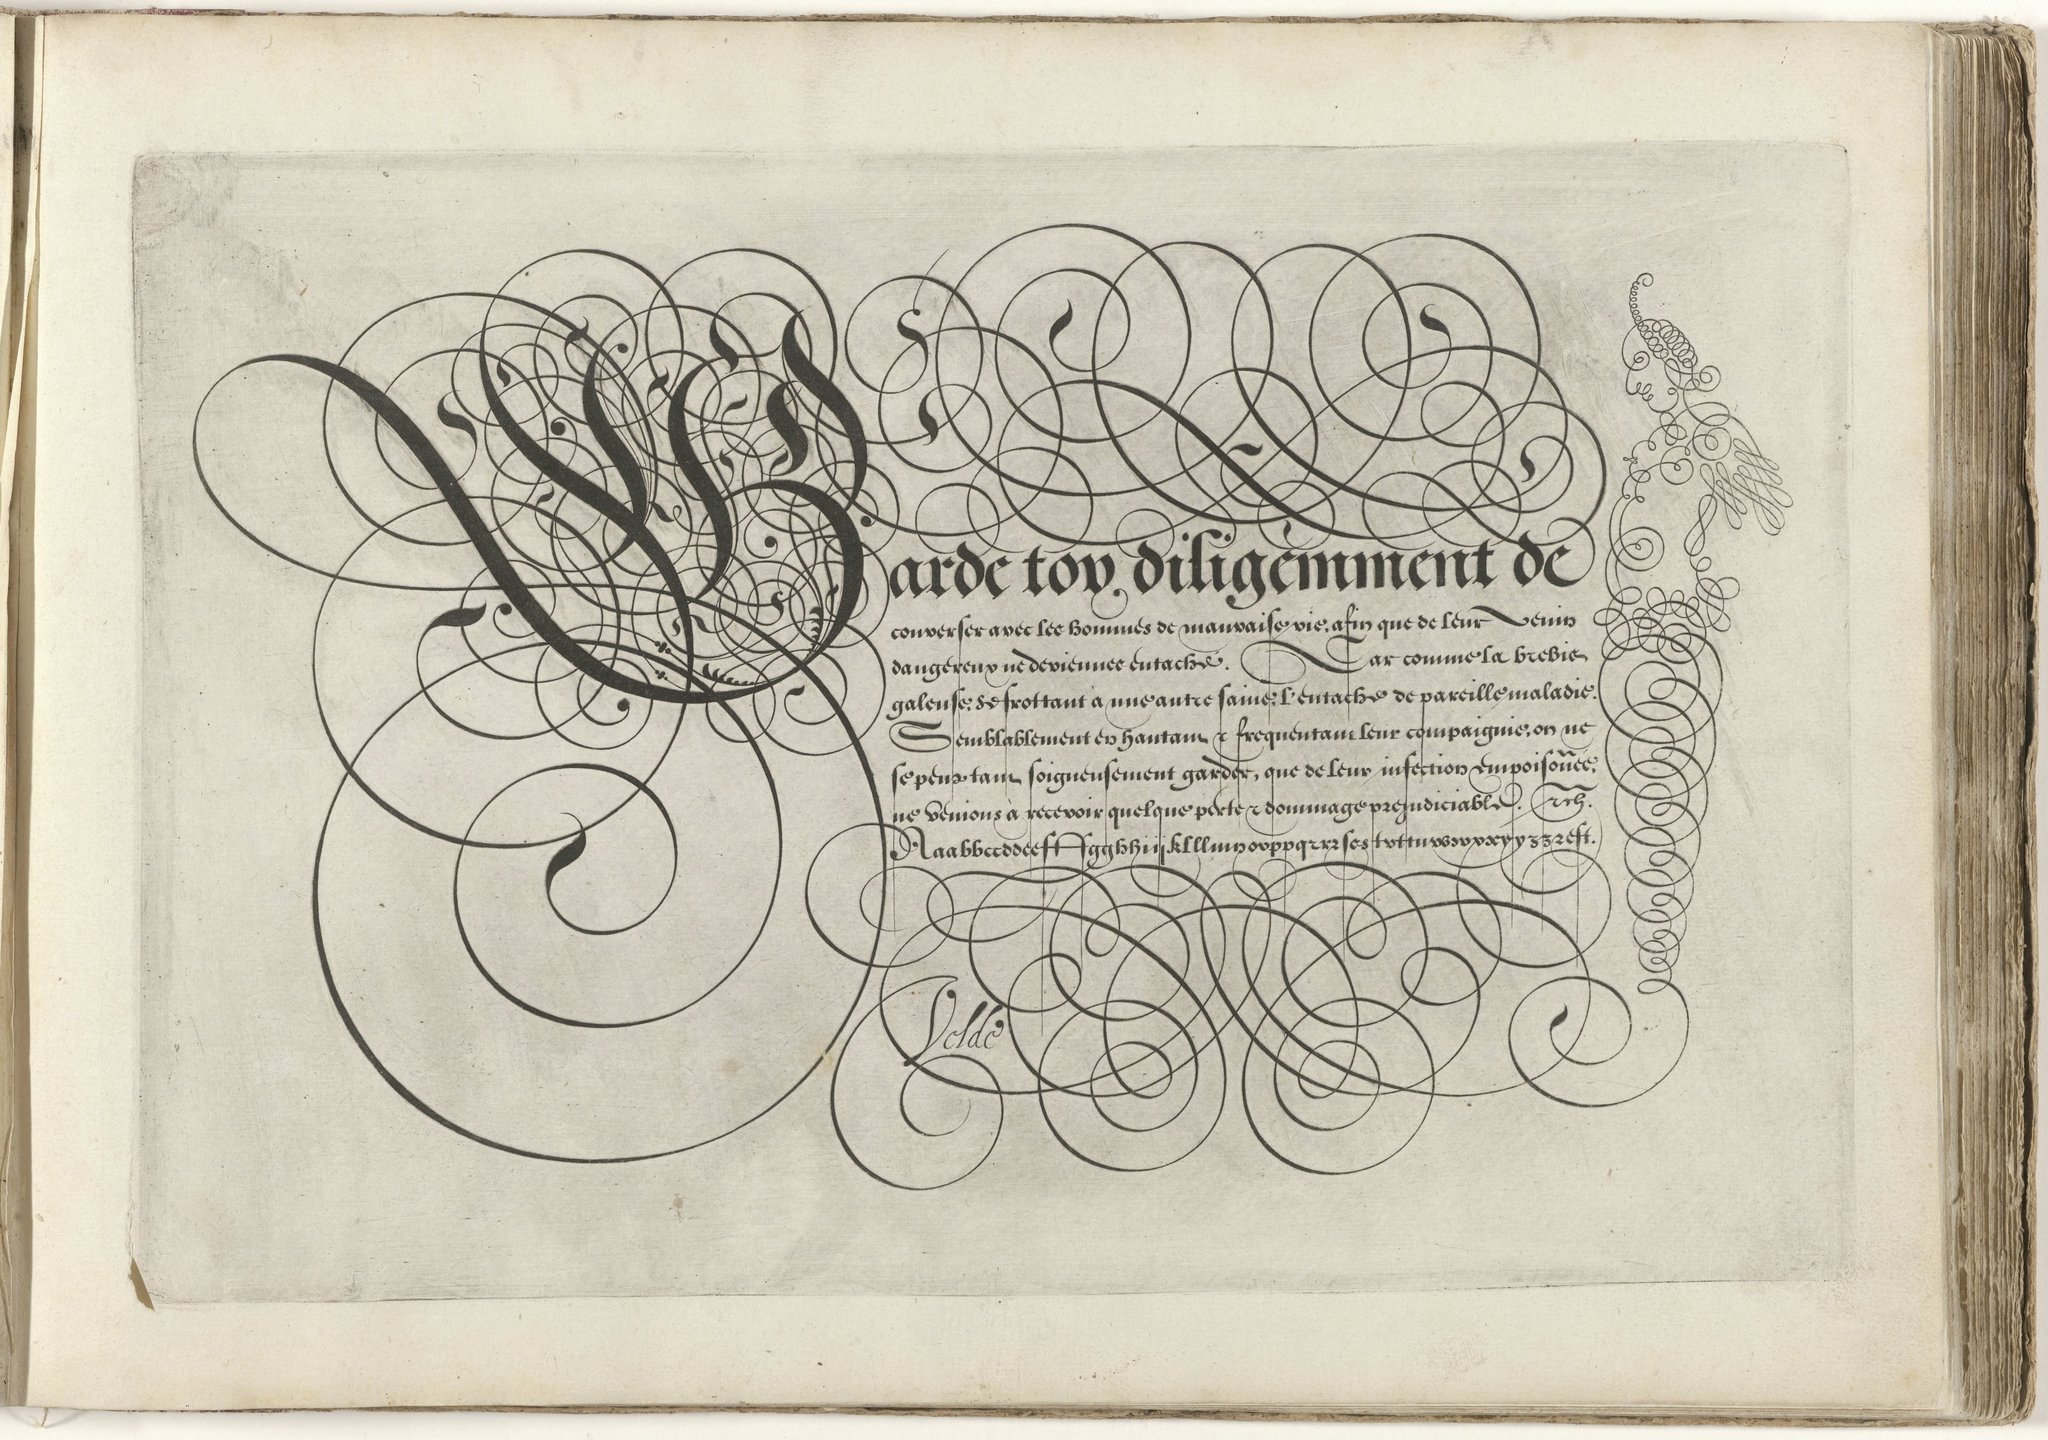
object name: ornament print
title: Schrijfvoorbeeld: Garde toy (...)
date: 1605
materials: paper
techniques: engraving, intaglio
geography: amsterdam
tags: calligraphy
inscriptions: collector's mark: Lugt 2228, collector's mark: Lugt 2760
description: Schrijfvoorbeeld met geornamenteerde initiaal G en zeven regels tekst in het Frans: Garde toy ... Onderaan een onderkastalfabet in de betreffende hand. De tekst is omlijst door krulwerk. Aan de rechterzijde een herme of grenszuil in krulwerk. De prent maakt deel uit van een album.